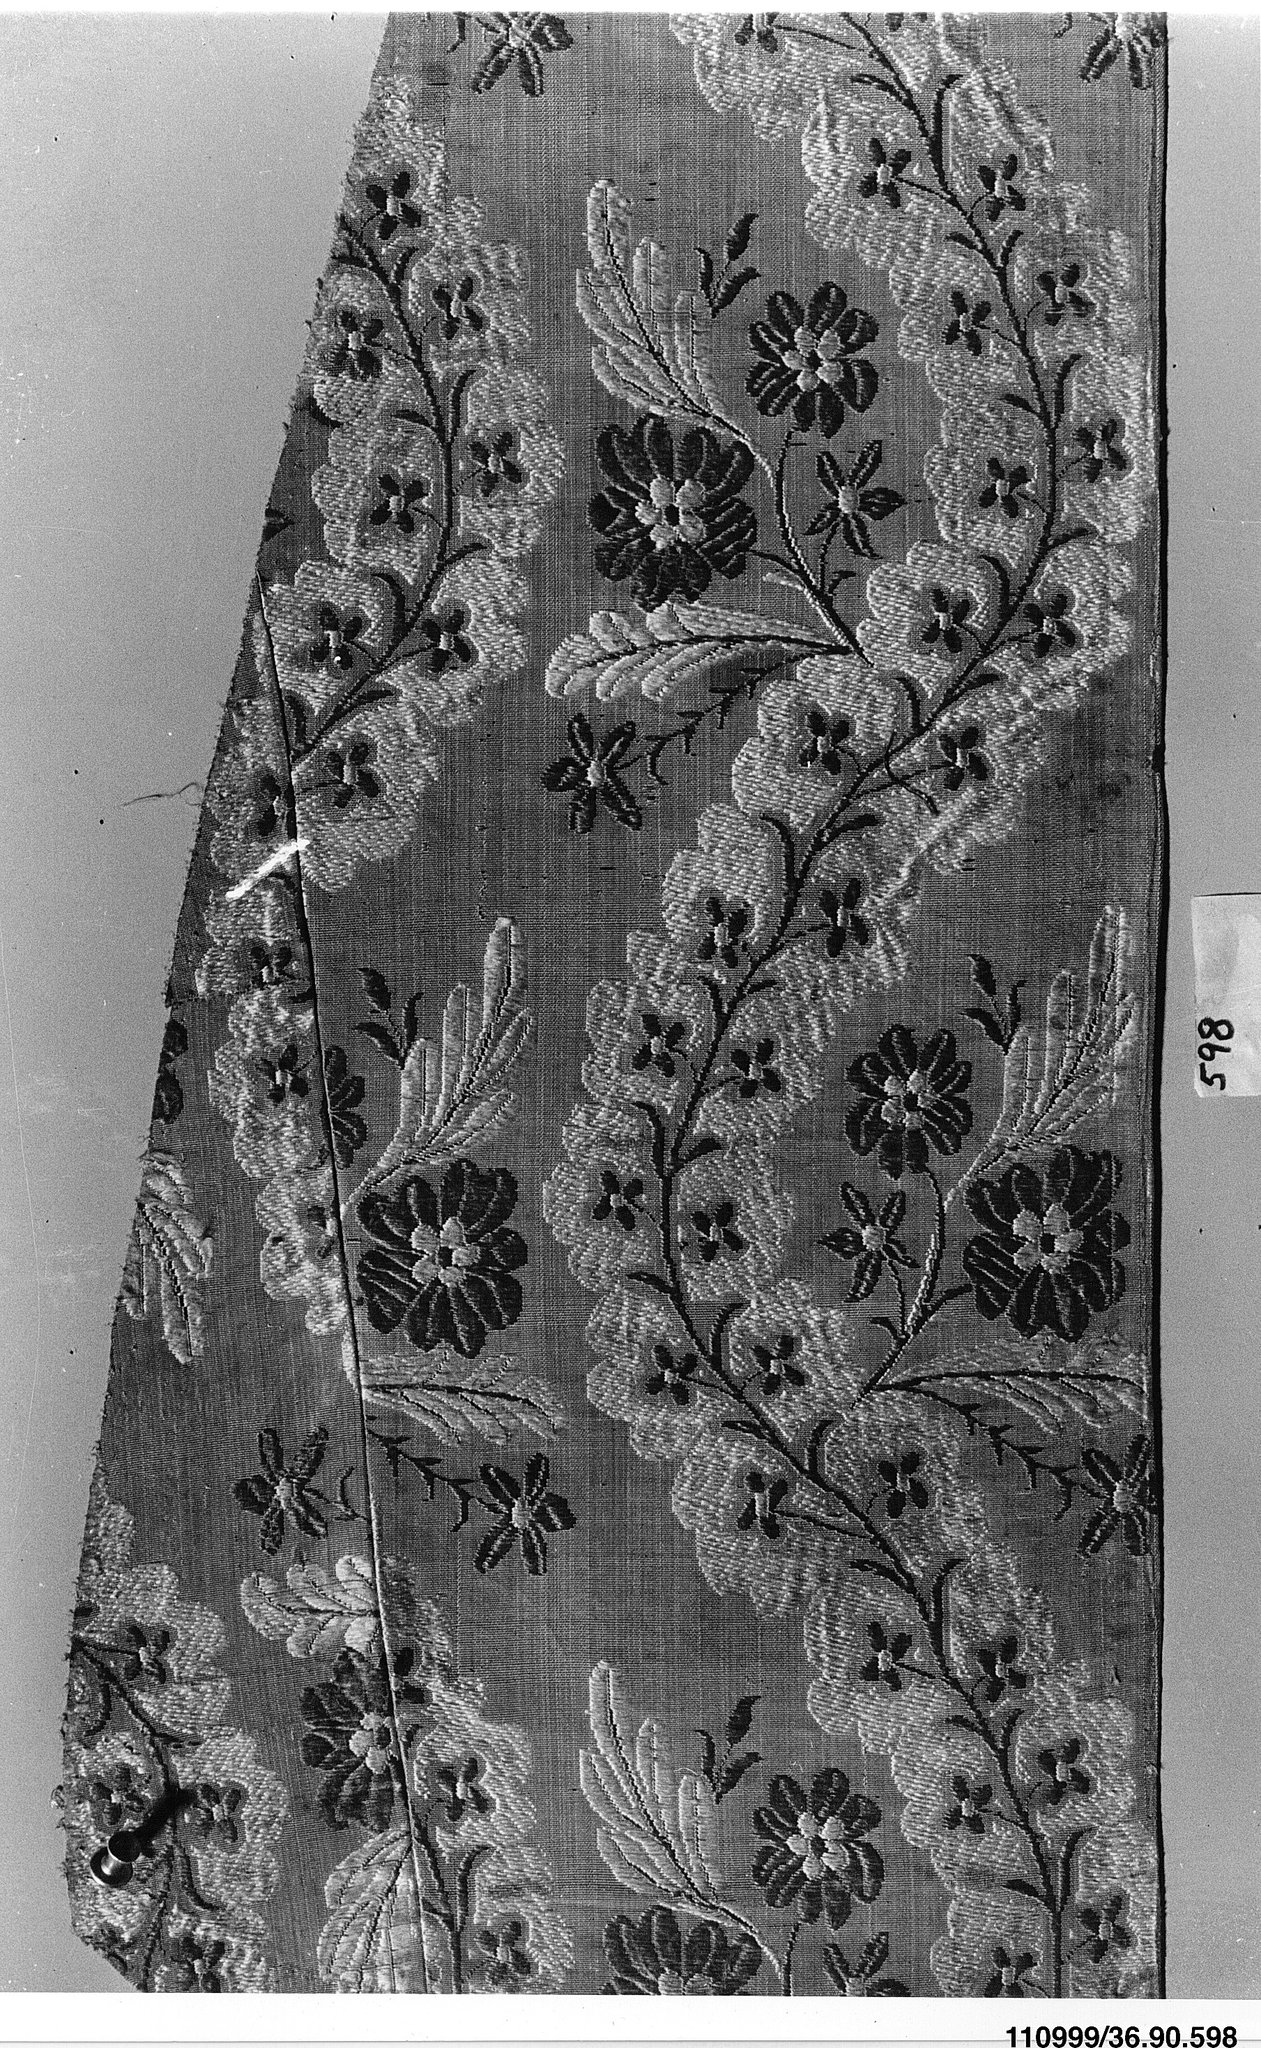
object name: piece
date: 1734-1766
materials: silk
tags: flowers,leaves